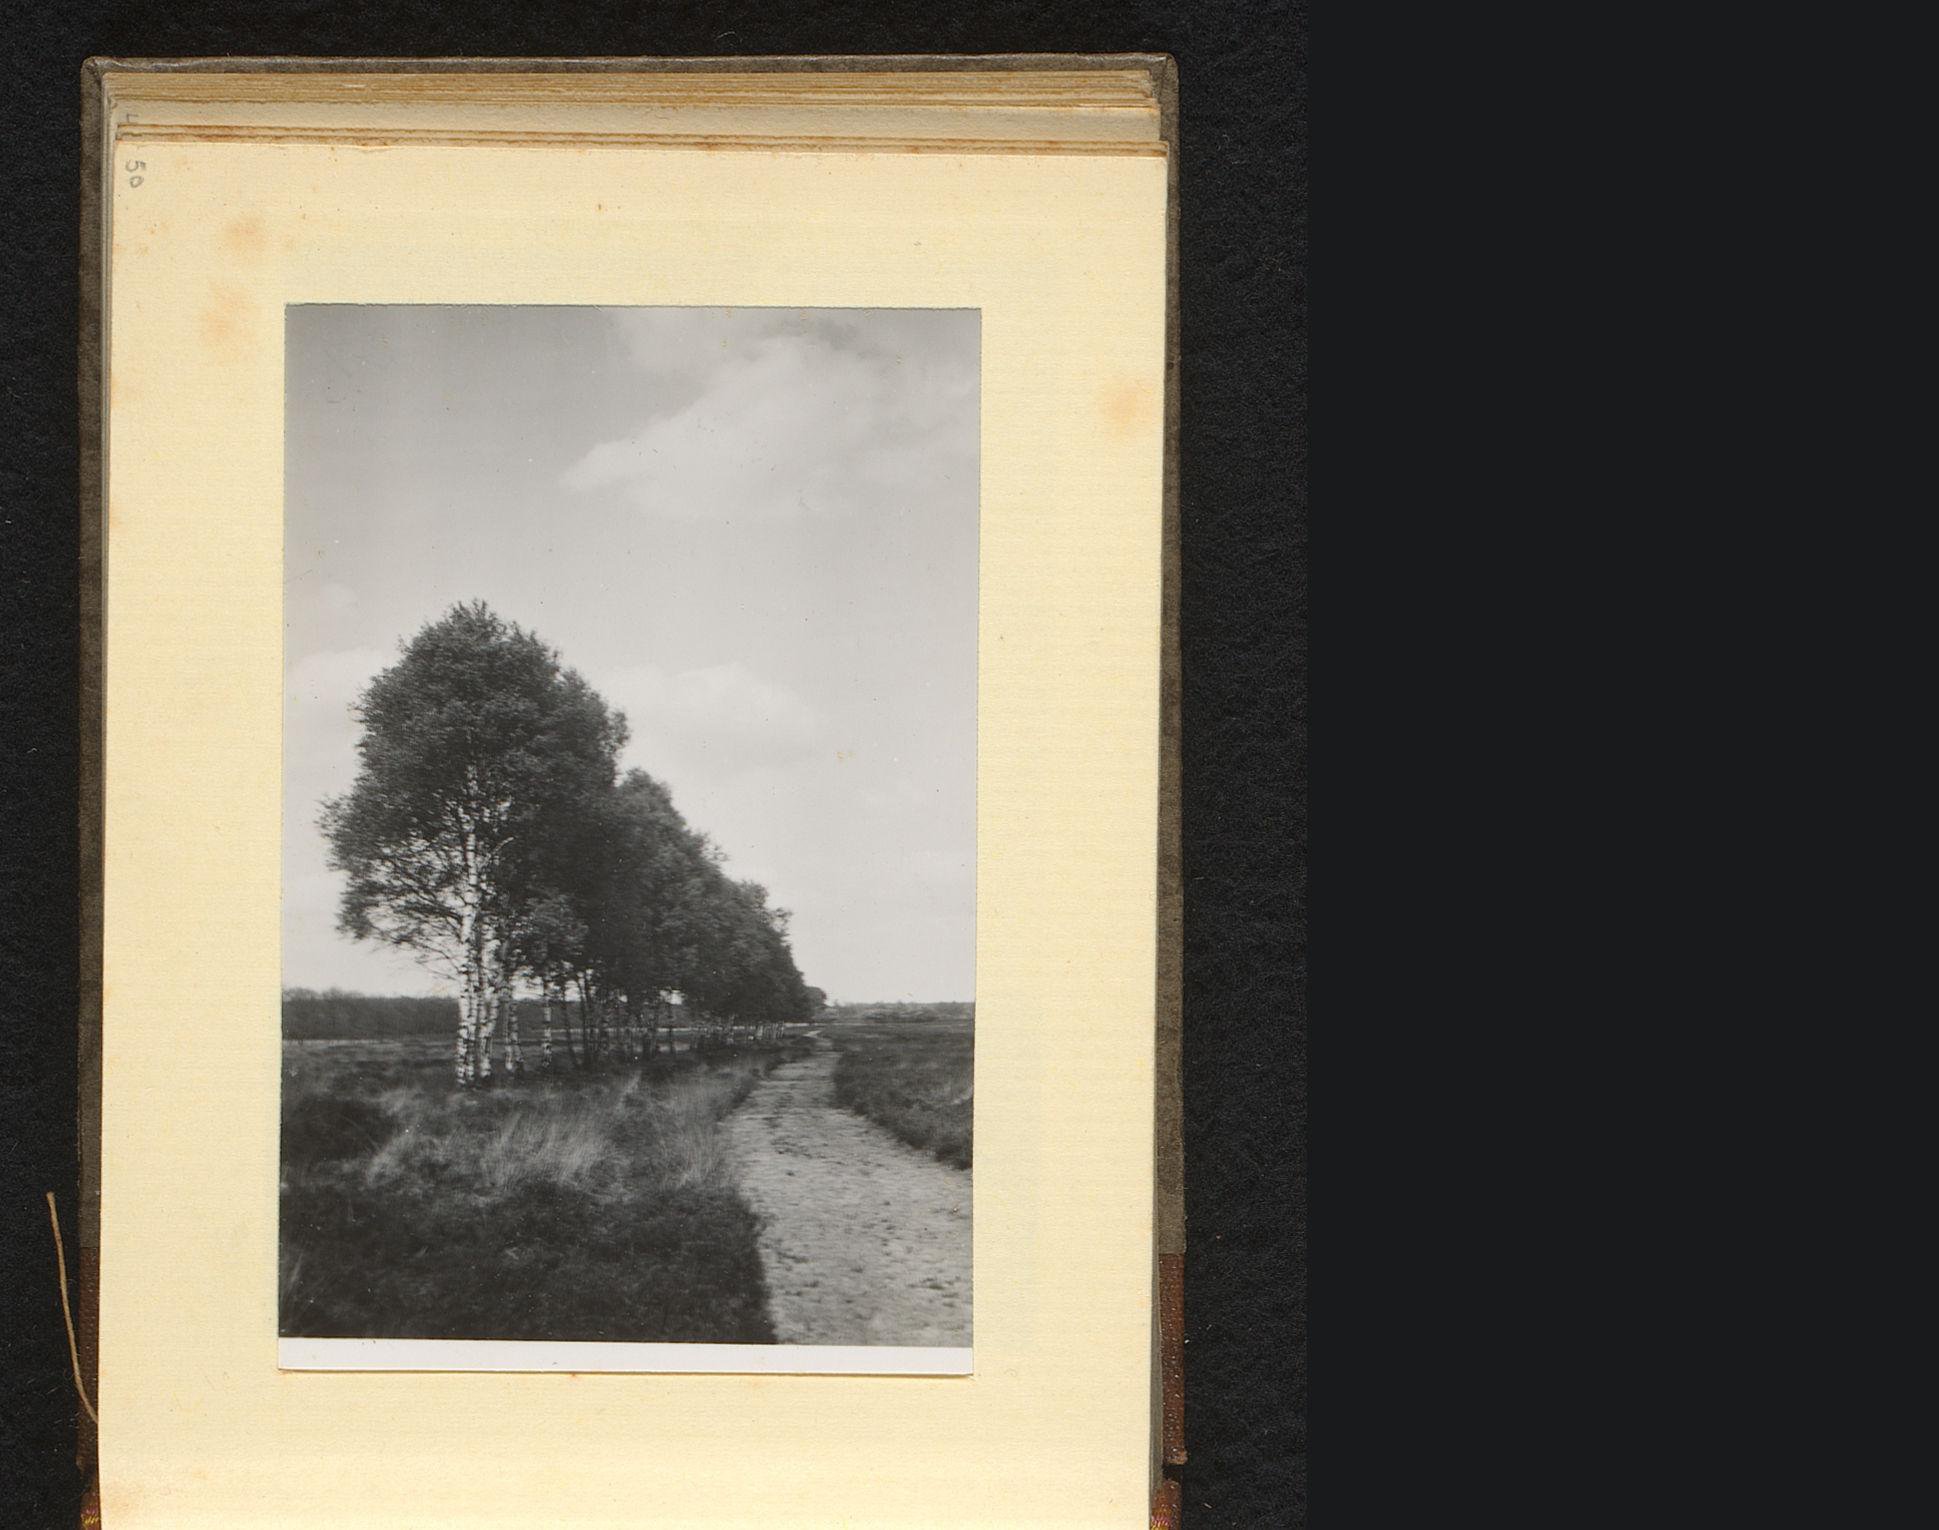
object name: album leaf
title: Zandweg in landschap met bomen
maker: norbert van den berg (1901-1972)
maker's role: amateurfotograaf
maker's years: 1901-1972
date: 1935-1950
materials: paper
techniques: gelatin silver print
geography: netherlands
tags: trees, road, path